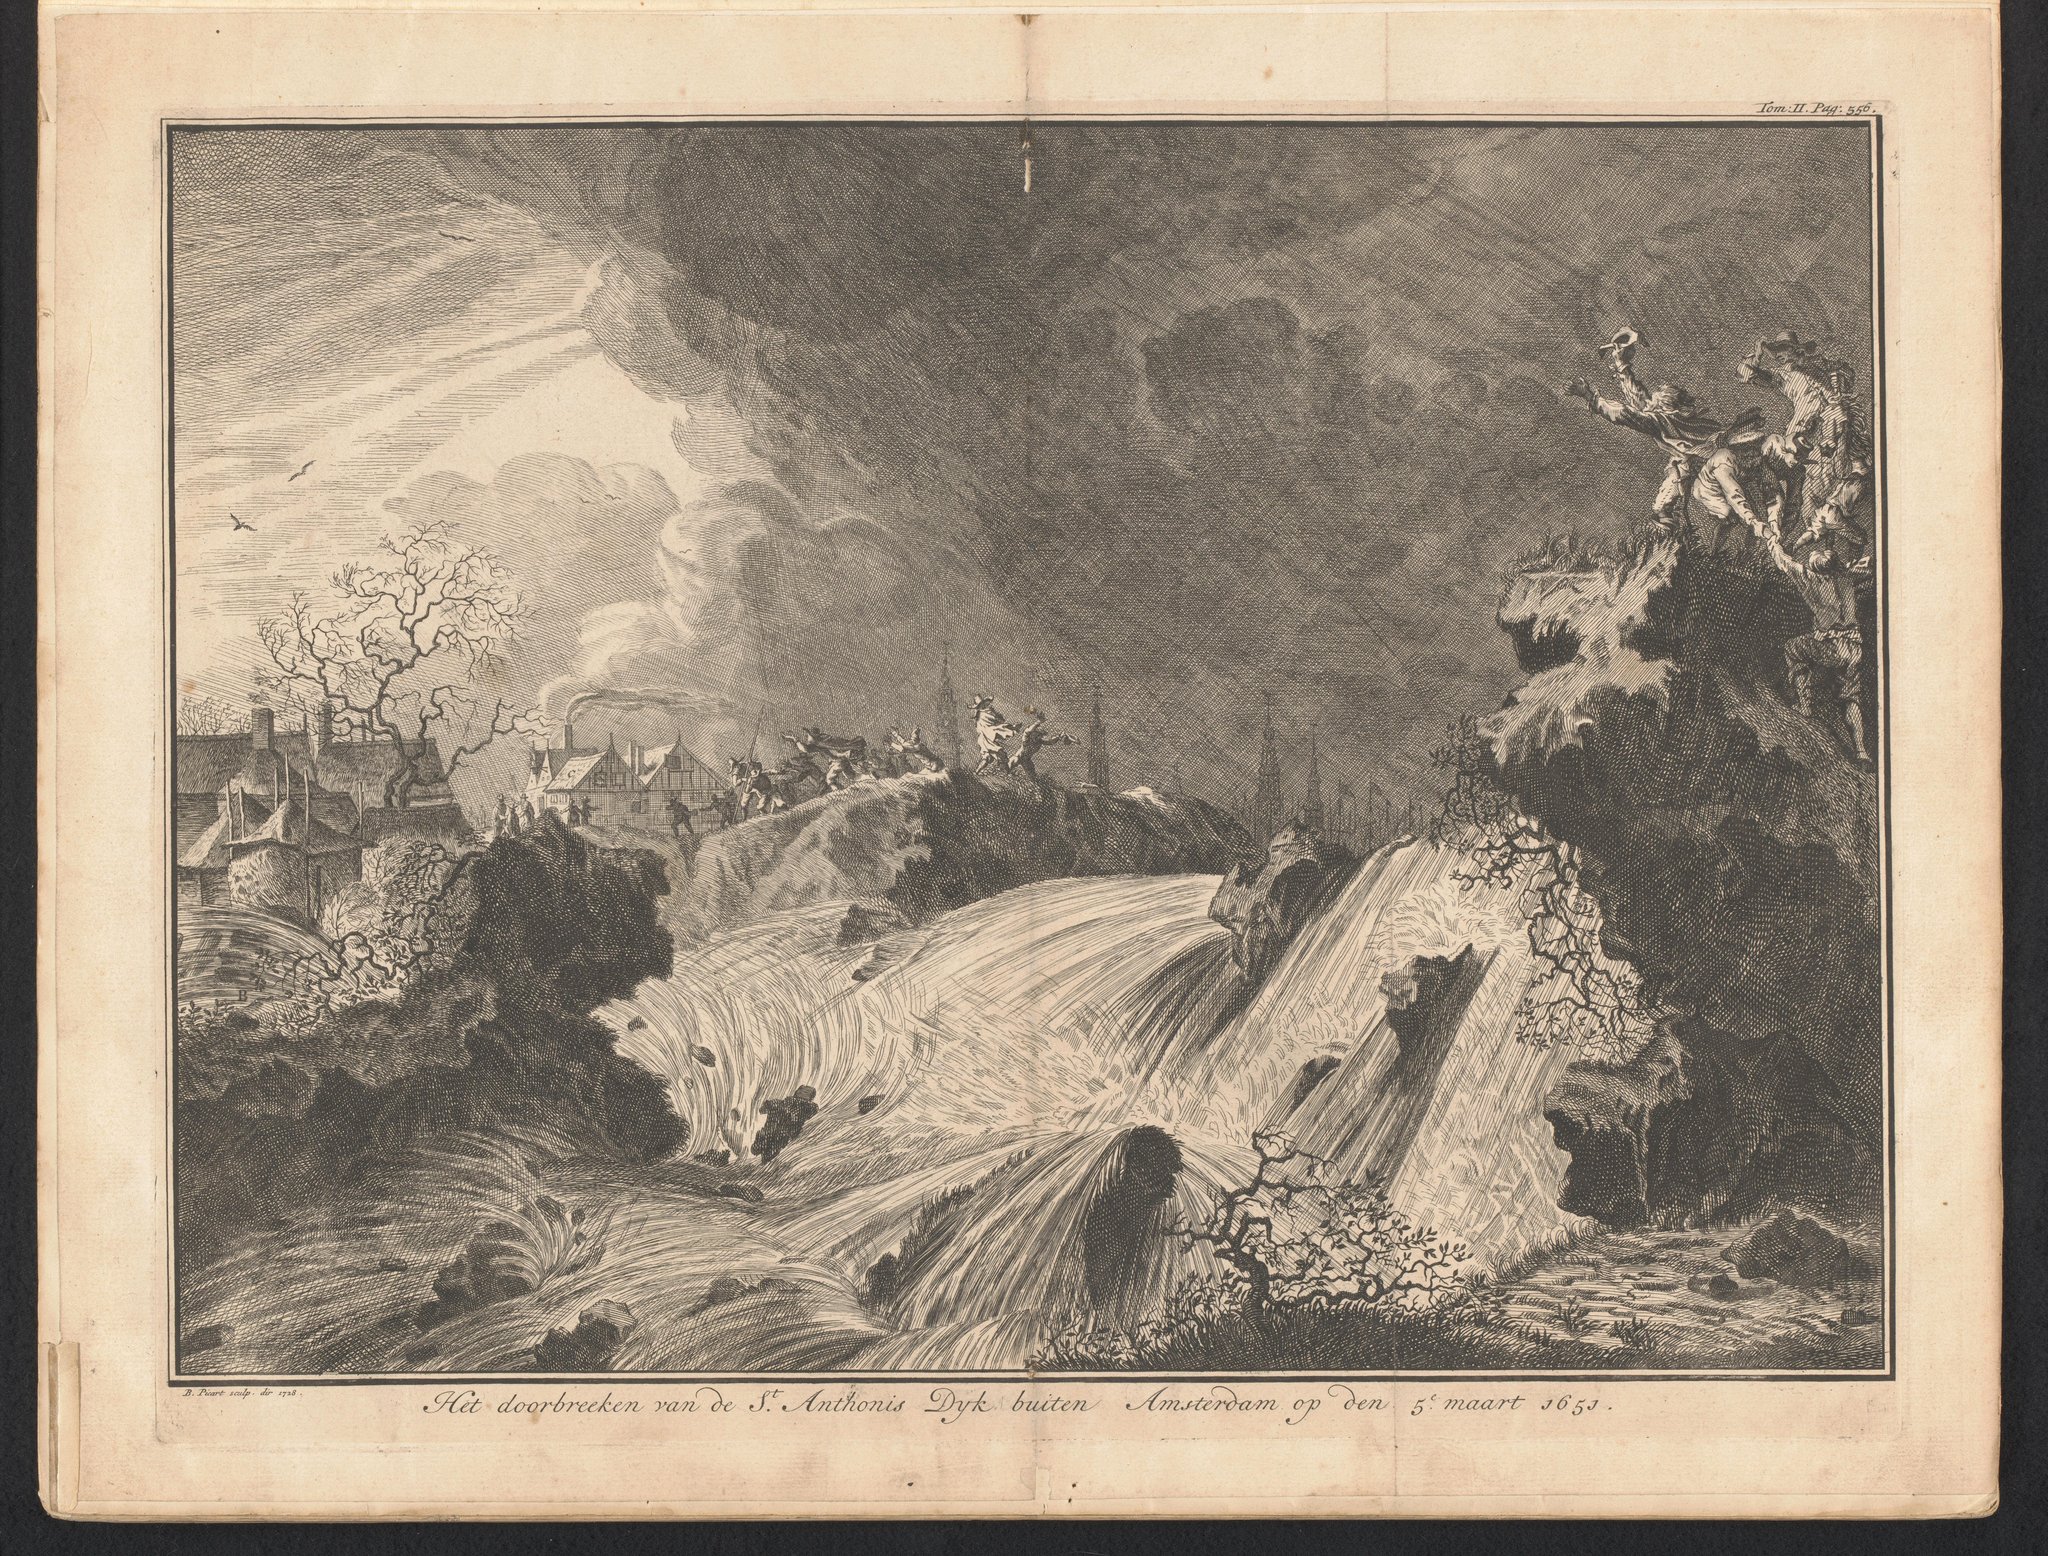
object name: album leaf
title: Het doorbreeken van de St. Anthonis Dyk buiten Amsterdam op den 5e. maart 1651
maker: bernard picart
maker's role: draughtsman, print maker, publisher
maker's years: 1673-1733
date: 1728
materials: paper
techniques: etching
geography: northern netherlands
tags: dike-break, confusion, bewilderment, panic; 'perturbatione' (ripa)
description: Prent gebruikt in: Le Clerc, Jean. Geschiedenissen der Vereenigde Nederlanden, sedert den aanvang van die Republyk tot op den Vrede van Utrecht in 't jaar 1713 en het Tractaat van Barriere in 't jaar 1715 gesloten. Amsterdam: Zacharias Chatelain, 1730, dl. 2, p. 556.